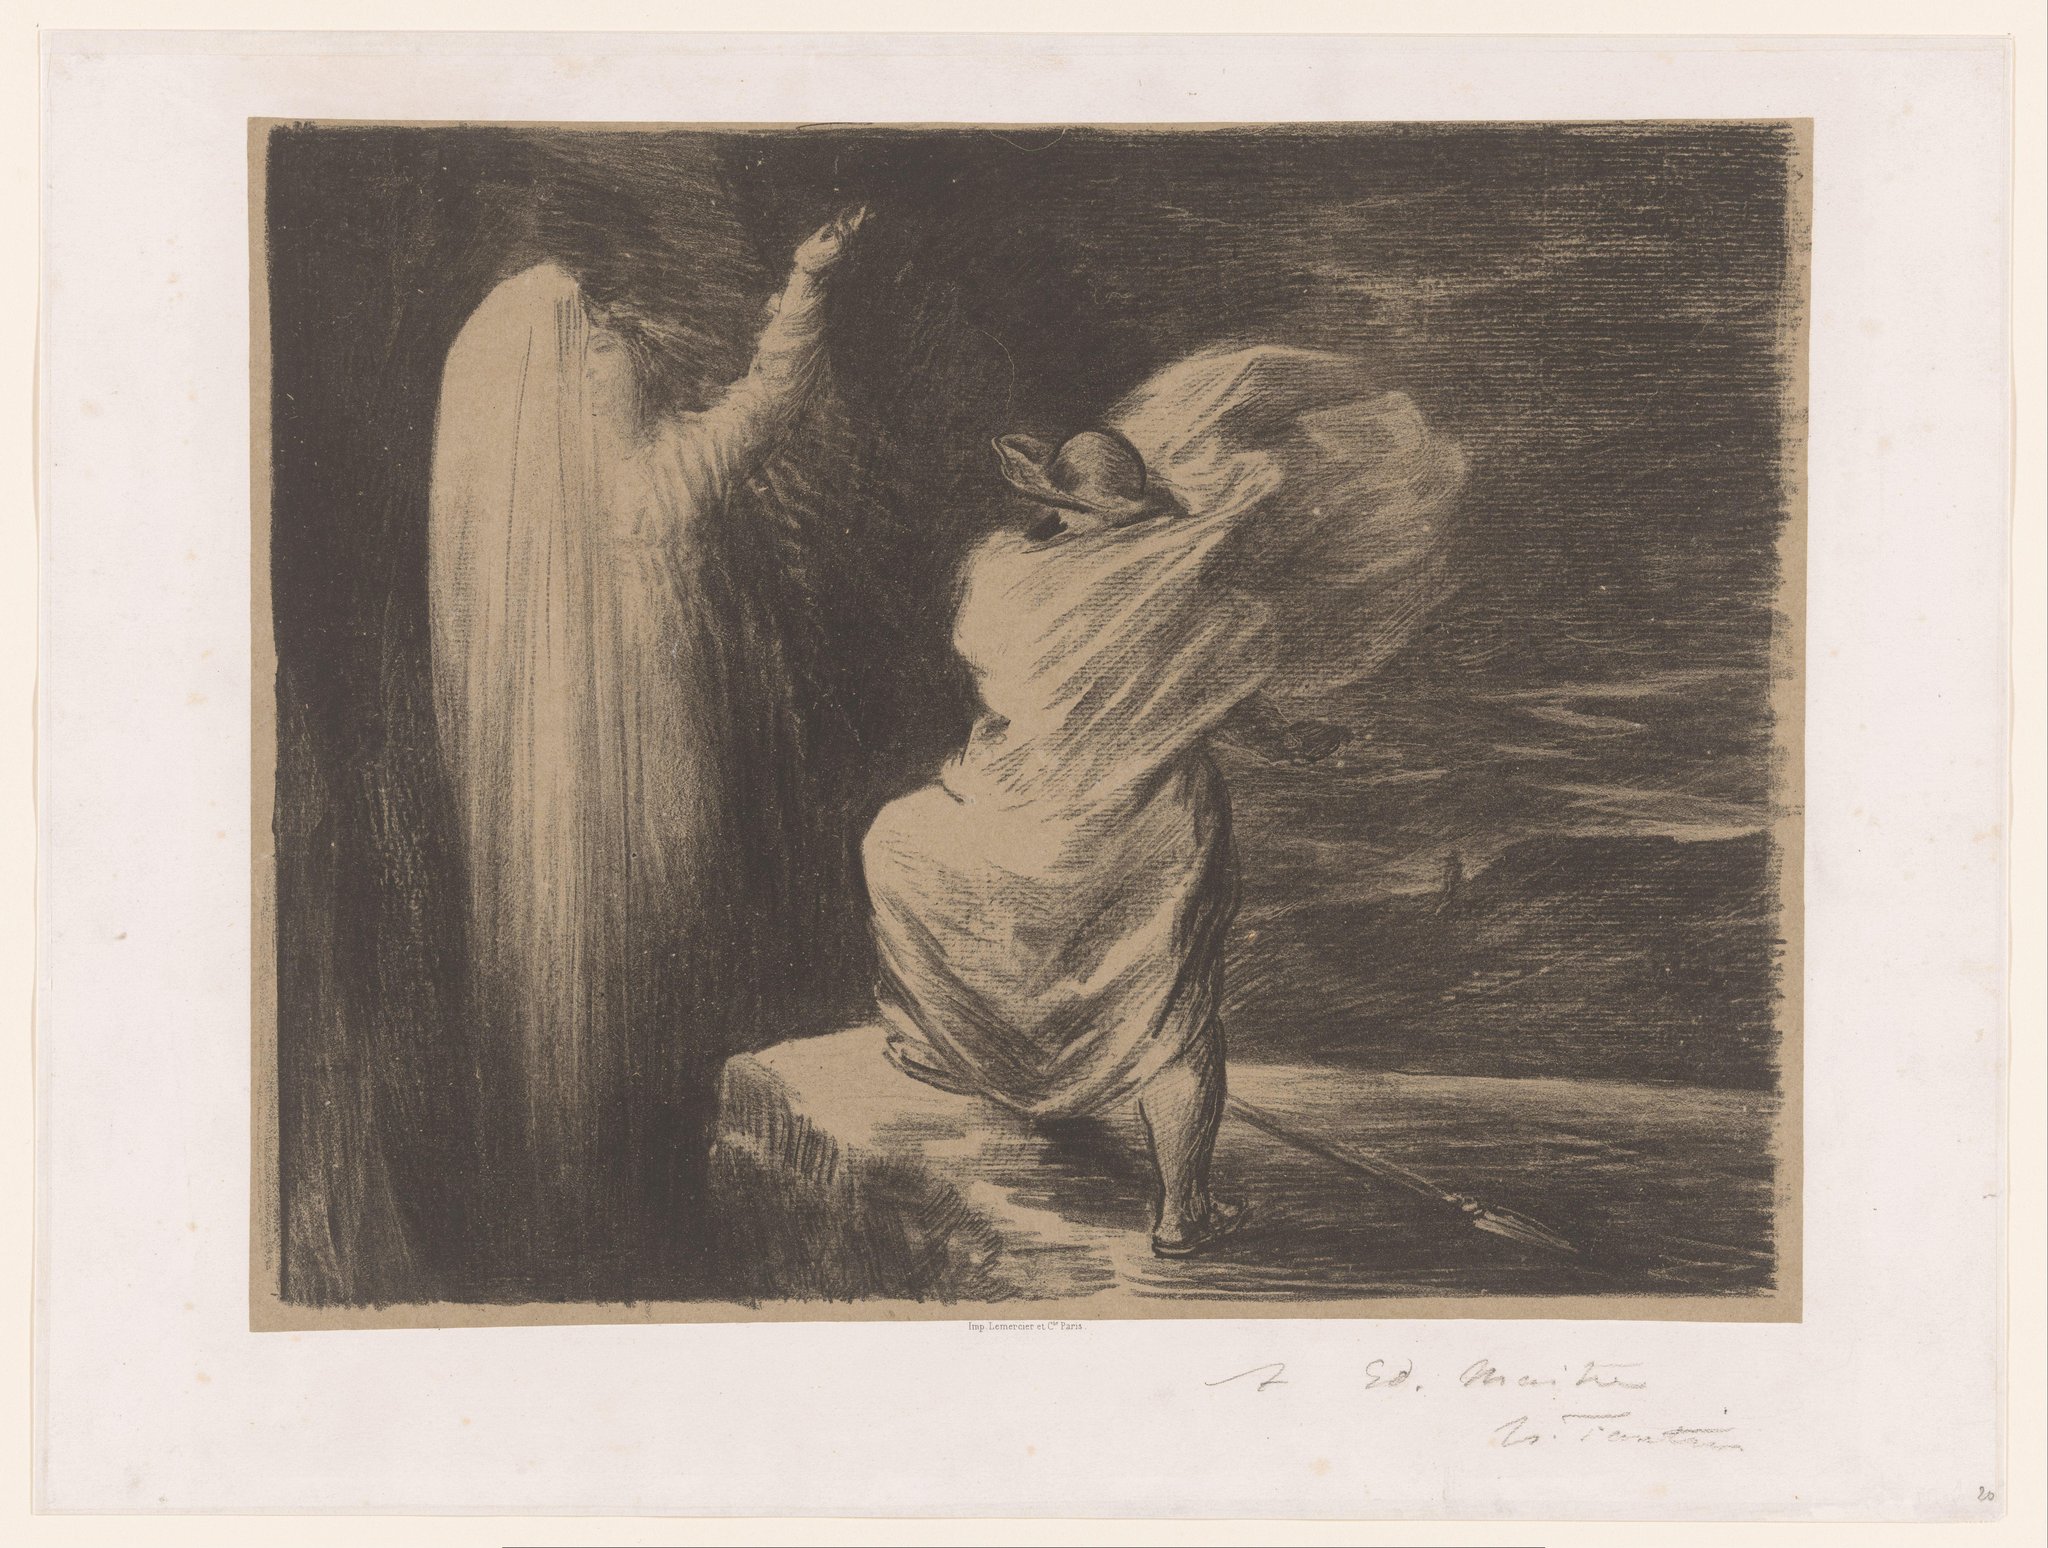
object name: print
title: Évocation d'Erda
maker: henri fantin-latour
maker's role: draughtsman, print maker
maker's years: 1836-1904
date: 1876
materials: paper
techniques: lithography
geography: paris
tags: evoking ghosts, conjuring up spirits, calling up genii, 'nibelungenlied'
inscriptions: collector's mark: Lugt 2228a, collector's mark: Lugt 2760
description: Wotan roept Erda op om haar advies in te winnen.